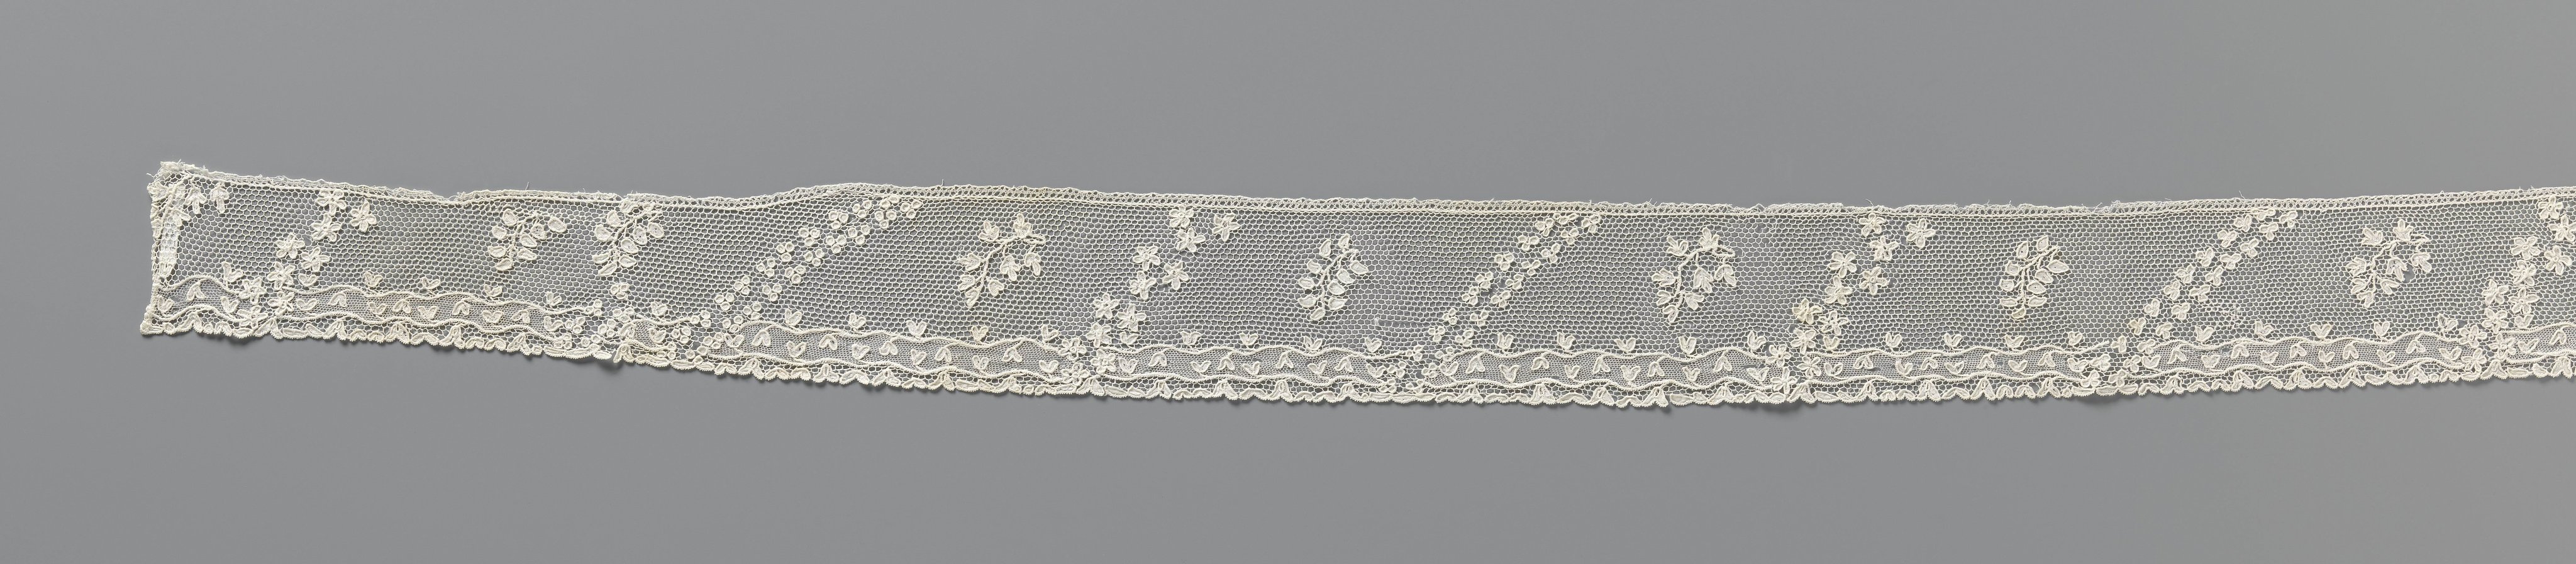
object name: strip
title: Strook naaldkant met dubbele diagonale lijnen en bladertakken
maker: Anonymous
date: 1600-1799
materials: linen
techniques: lace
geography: southern netherlands